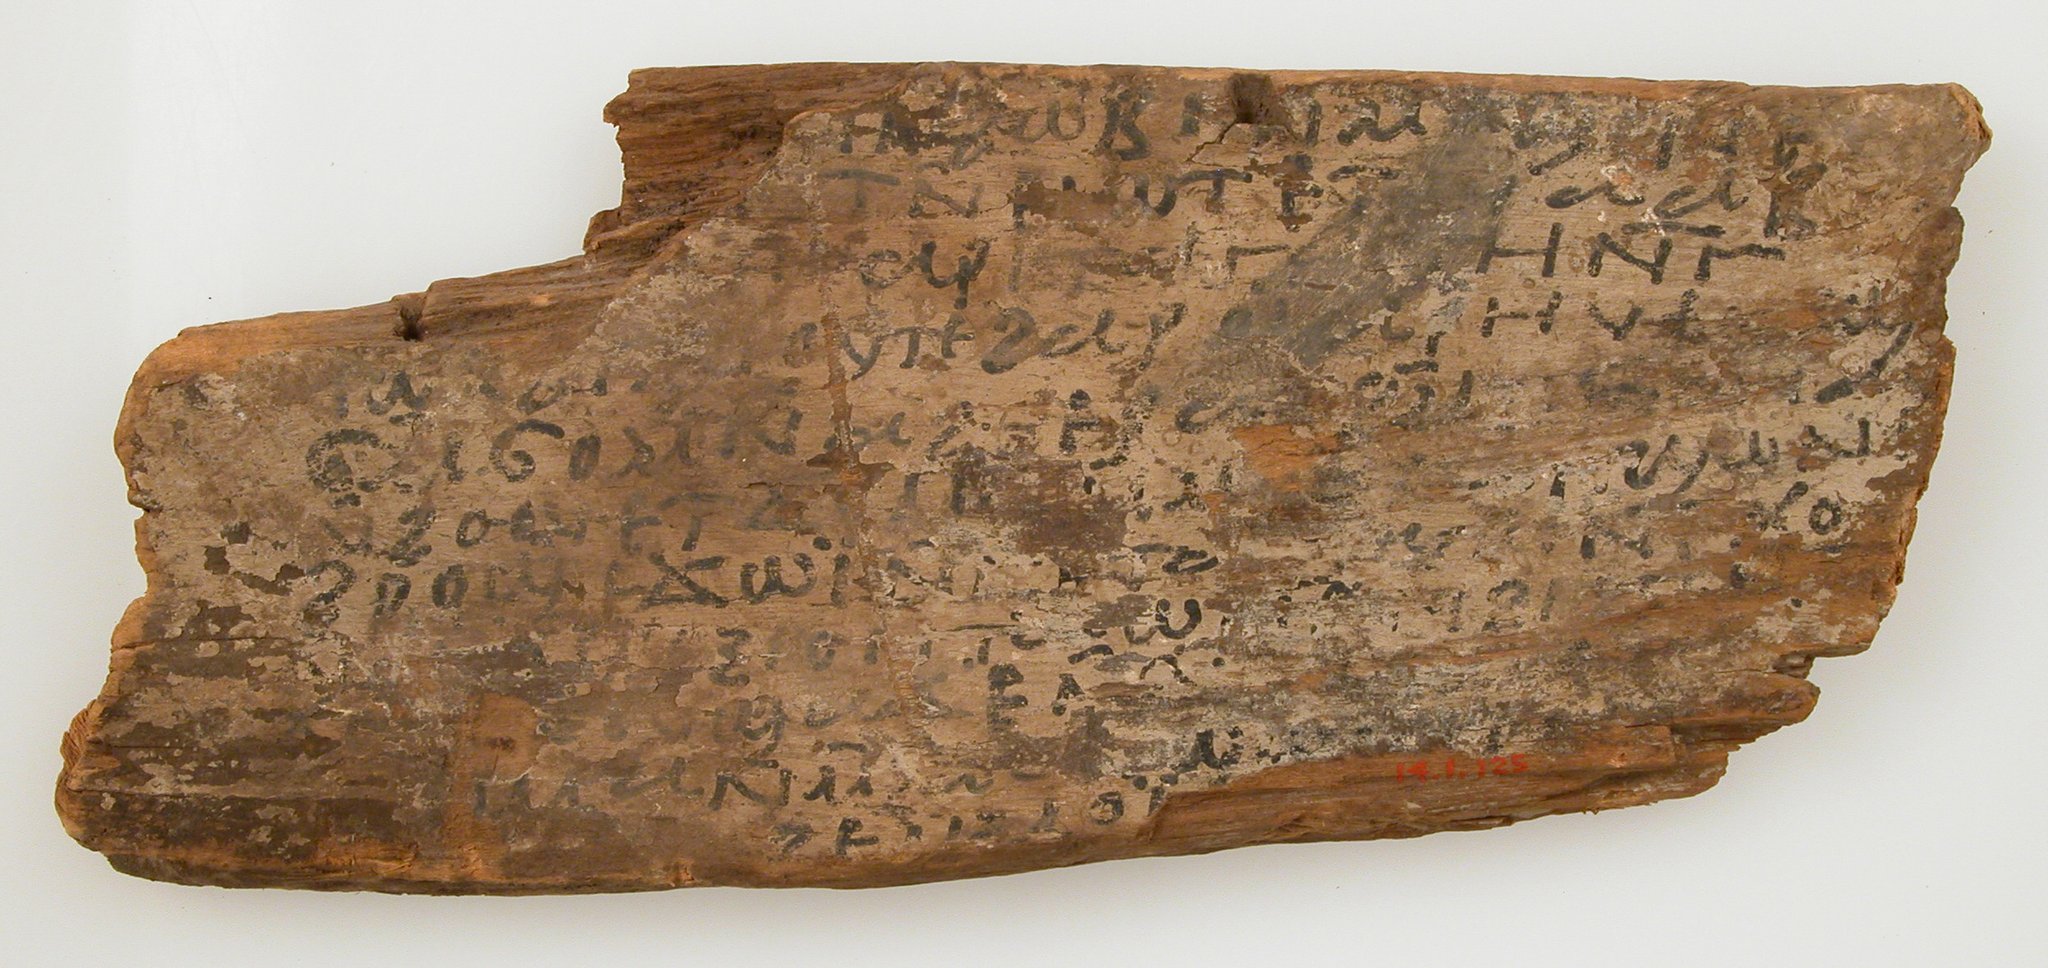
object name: ostrakon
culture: coptic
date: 600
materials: ink, wood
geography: egypt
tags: coptic,documents